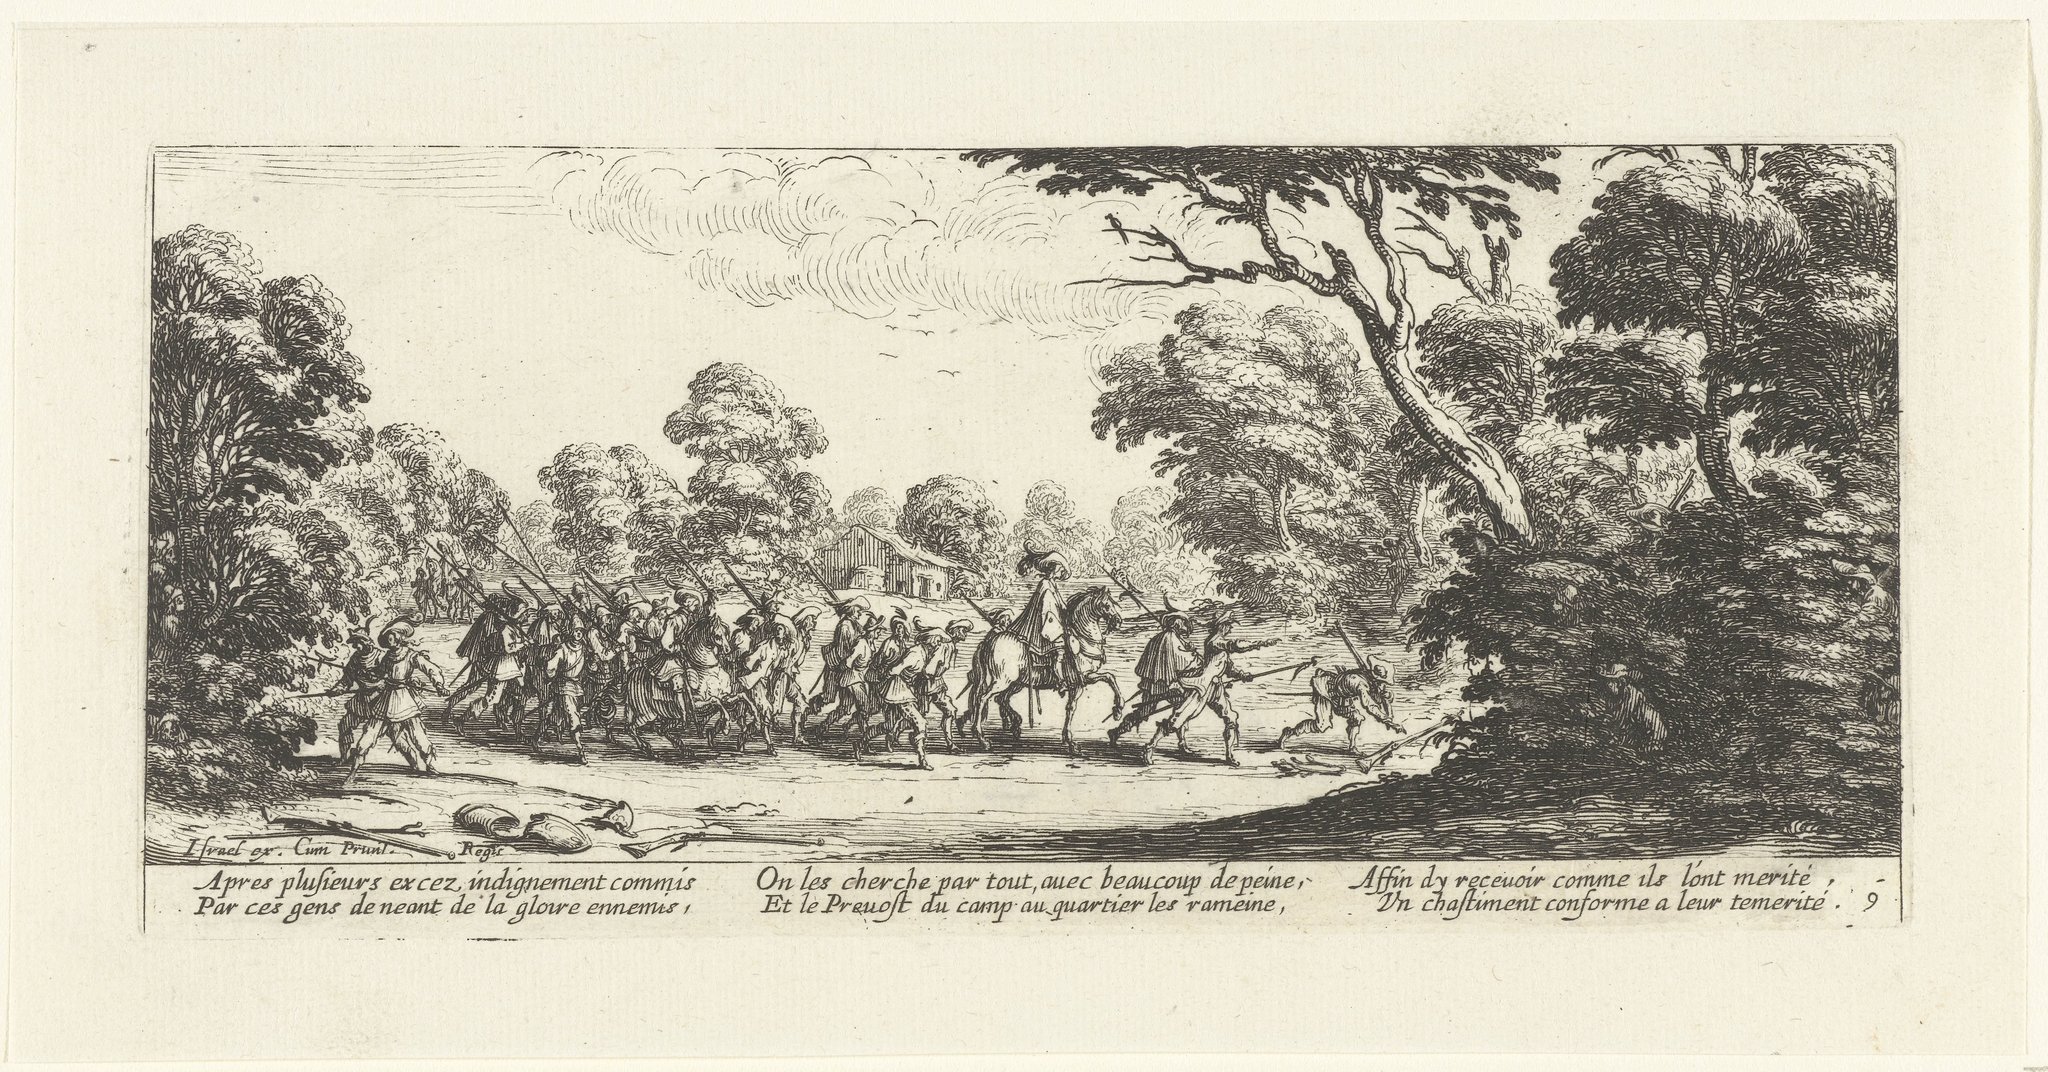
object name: print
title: De gruwelen van de oorlog (groot)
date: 1633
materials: paper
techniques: etching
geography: nancy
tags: arrest ~ military service, military police, provost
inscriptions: collector's mark: Lugt 240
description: Enkele soldaten te paard en te voet voeren collega's die zich misdragen hebben als gevangenen mee, ondertussen zoekend naar meer te berechten soldaten. Rechts en links zitten er een aantal verstopt in het struikgewas. Onder de voorstelling een zesregelig Frans vers. Deze prent is onderdeel van een serie van 17 (18 incl. titelprent) prenten met voorstellingen van diverse soorten ellende die oorlogvoering met zich meebrengt.